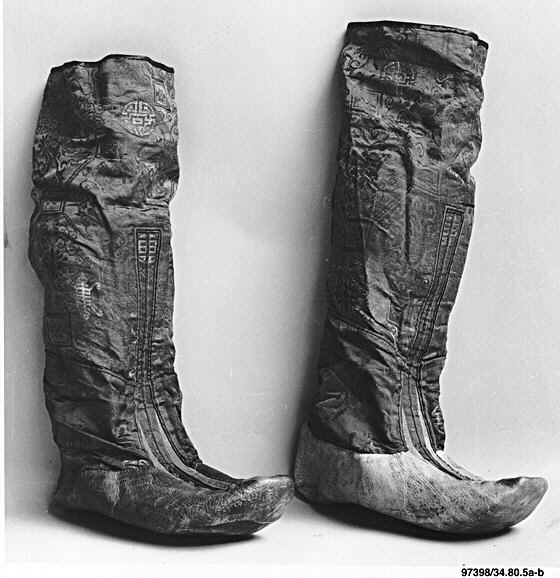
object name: shoe, lamaist priest's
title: Lamaist Priest's Shoes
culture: china or tibet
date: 1801-1833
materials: leather, silk